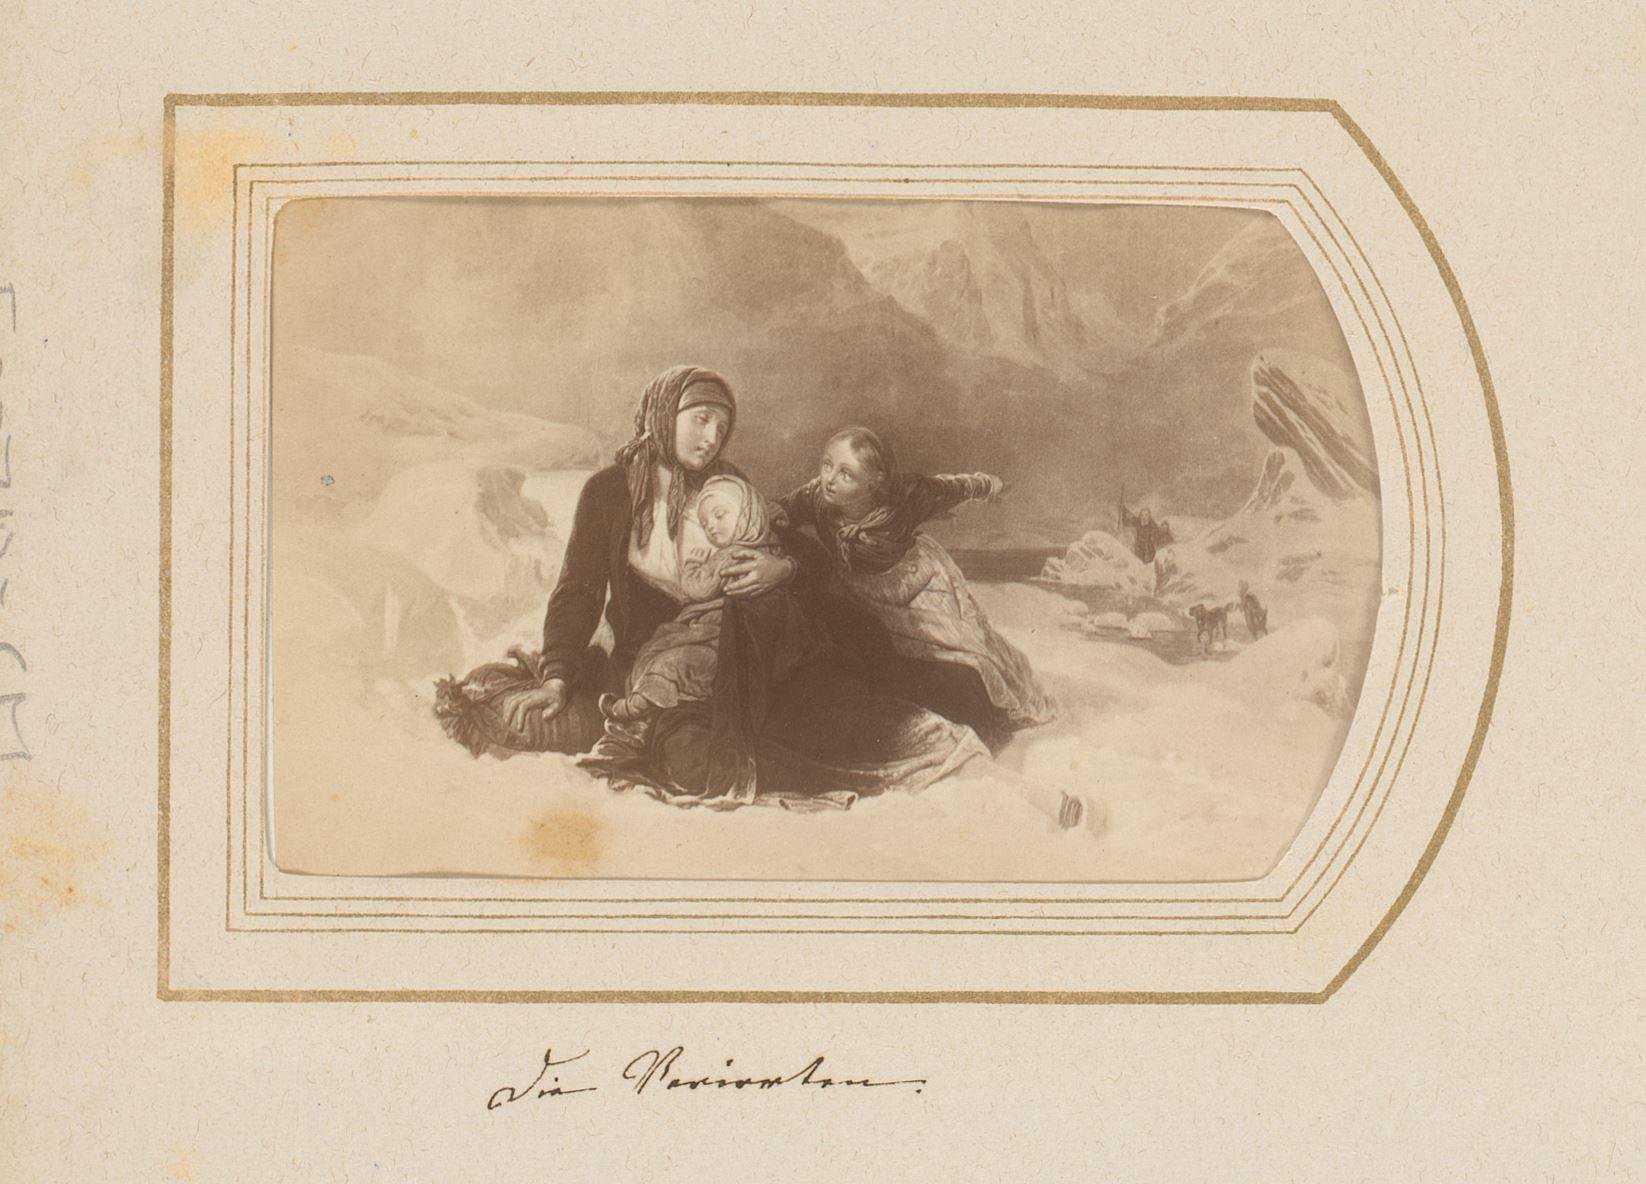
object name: album leaf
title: Fotoreproductie van Les egarees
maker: Anonymous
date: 1870-1890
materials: cardboard, photographic support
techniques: albumen print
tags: adult woman, child, painting, drawing and the graphic arts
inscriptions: annotation: ‘Die [...]’, number: ‘2978’